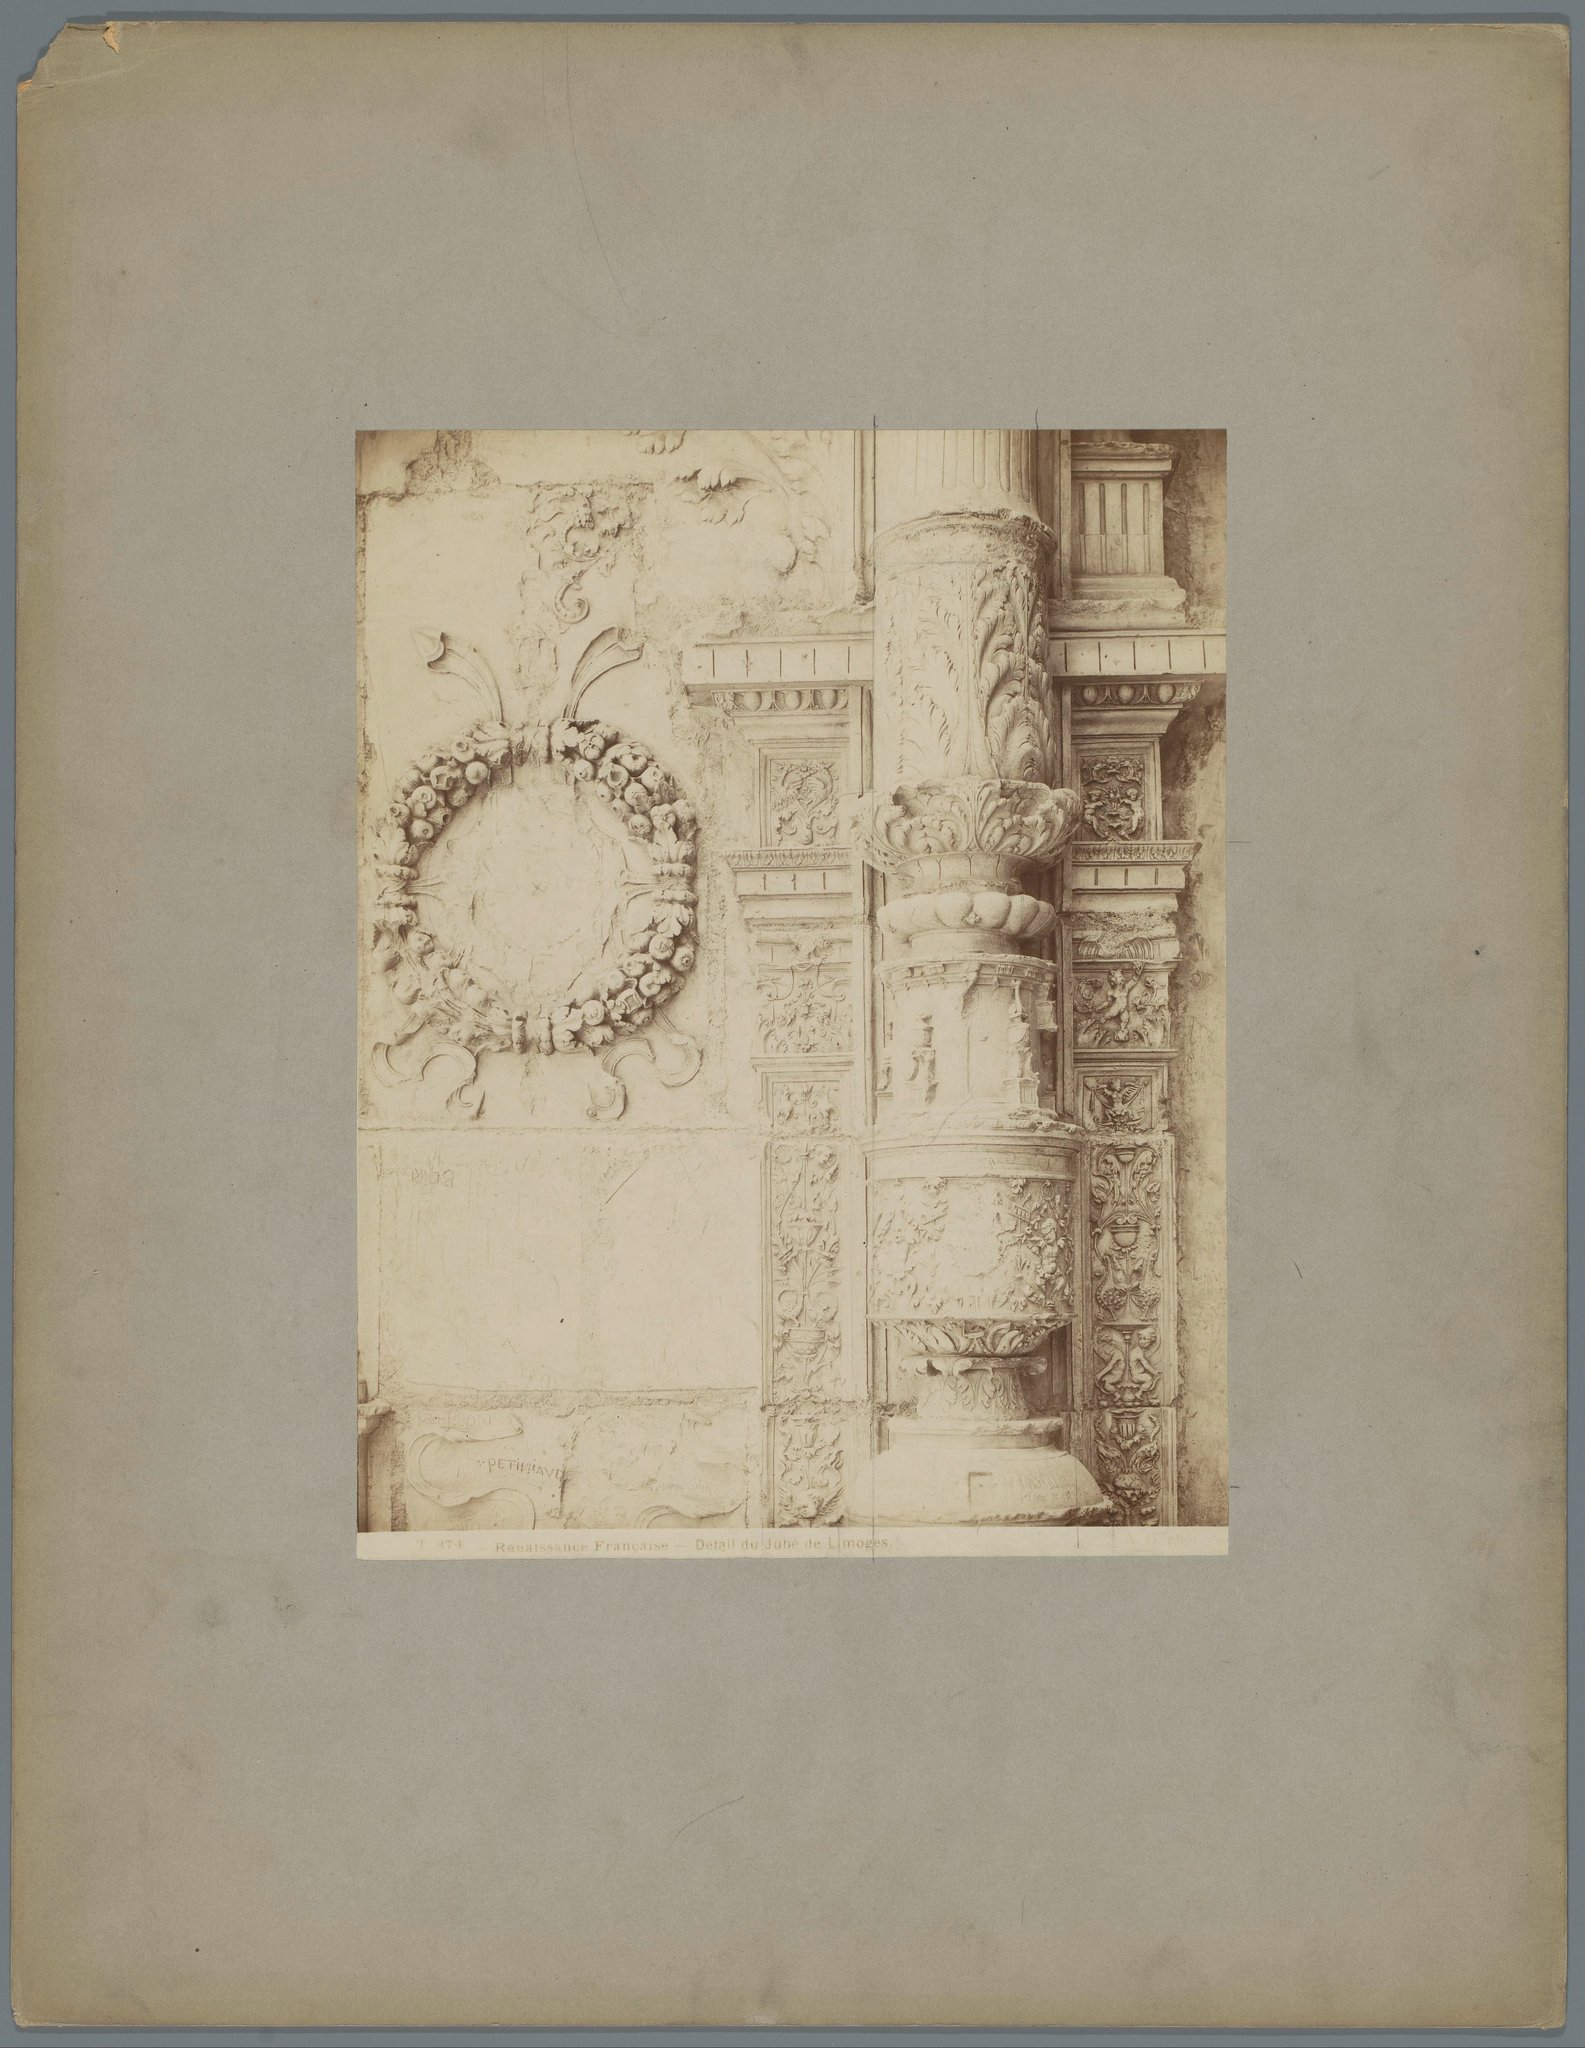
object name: photograph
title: Detail van het doksaal in de Kathedraal van Limoges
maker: adolphe giraudon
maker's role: publisher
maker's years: 1849-1929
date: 1875-1900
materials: cardboard, photographic support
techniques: albumen print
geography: limoges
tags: rood-screen, choir-screen; iconostasis, sculpture (+ relief ~ sculpture)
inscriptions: number: ‘T 374’, collector's mark: Lugt 3937